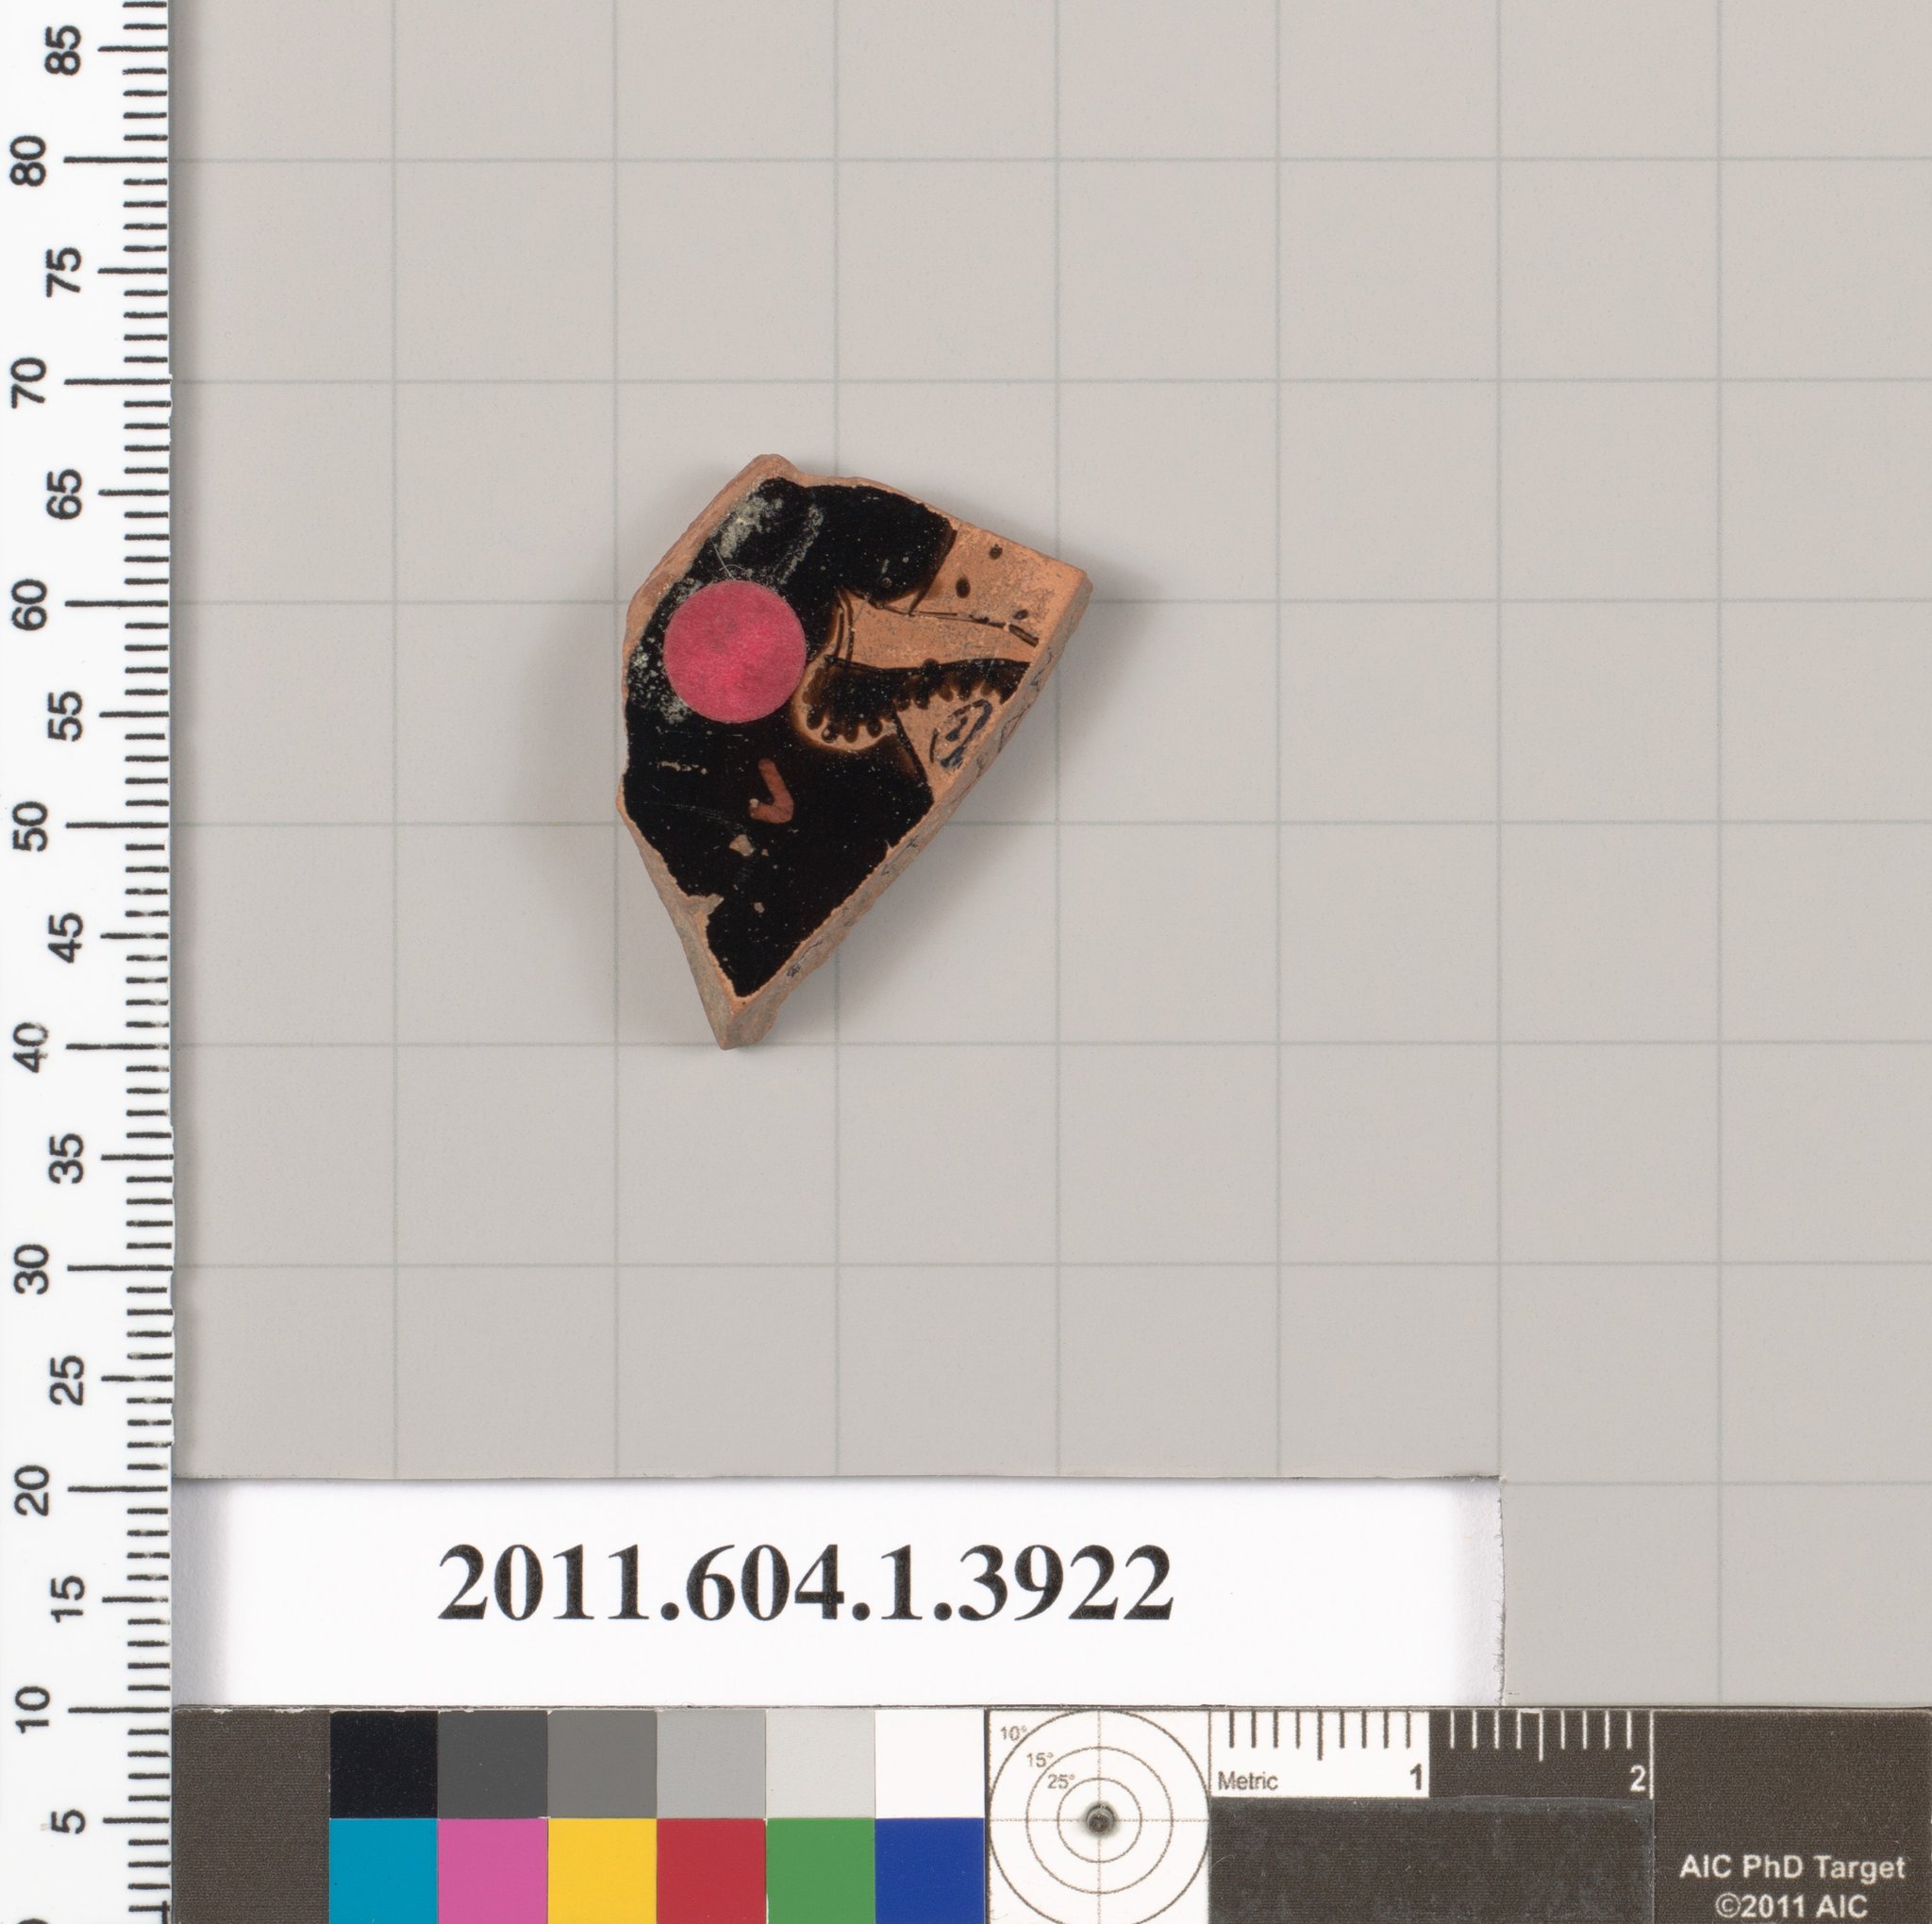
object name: kylix fragment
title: Terracotta fragment of a kylix (drinking cup)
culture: greek, attic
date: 510-490 BCE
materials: terracotta